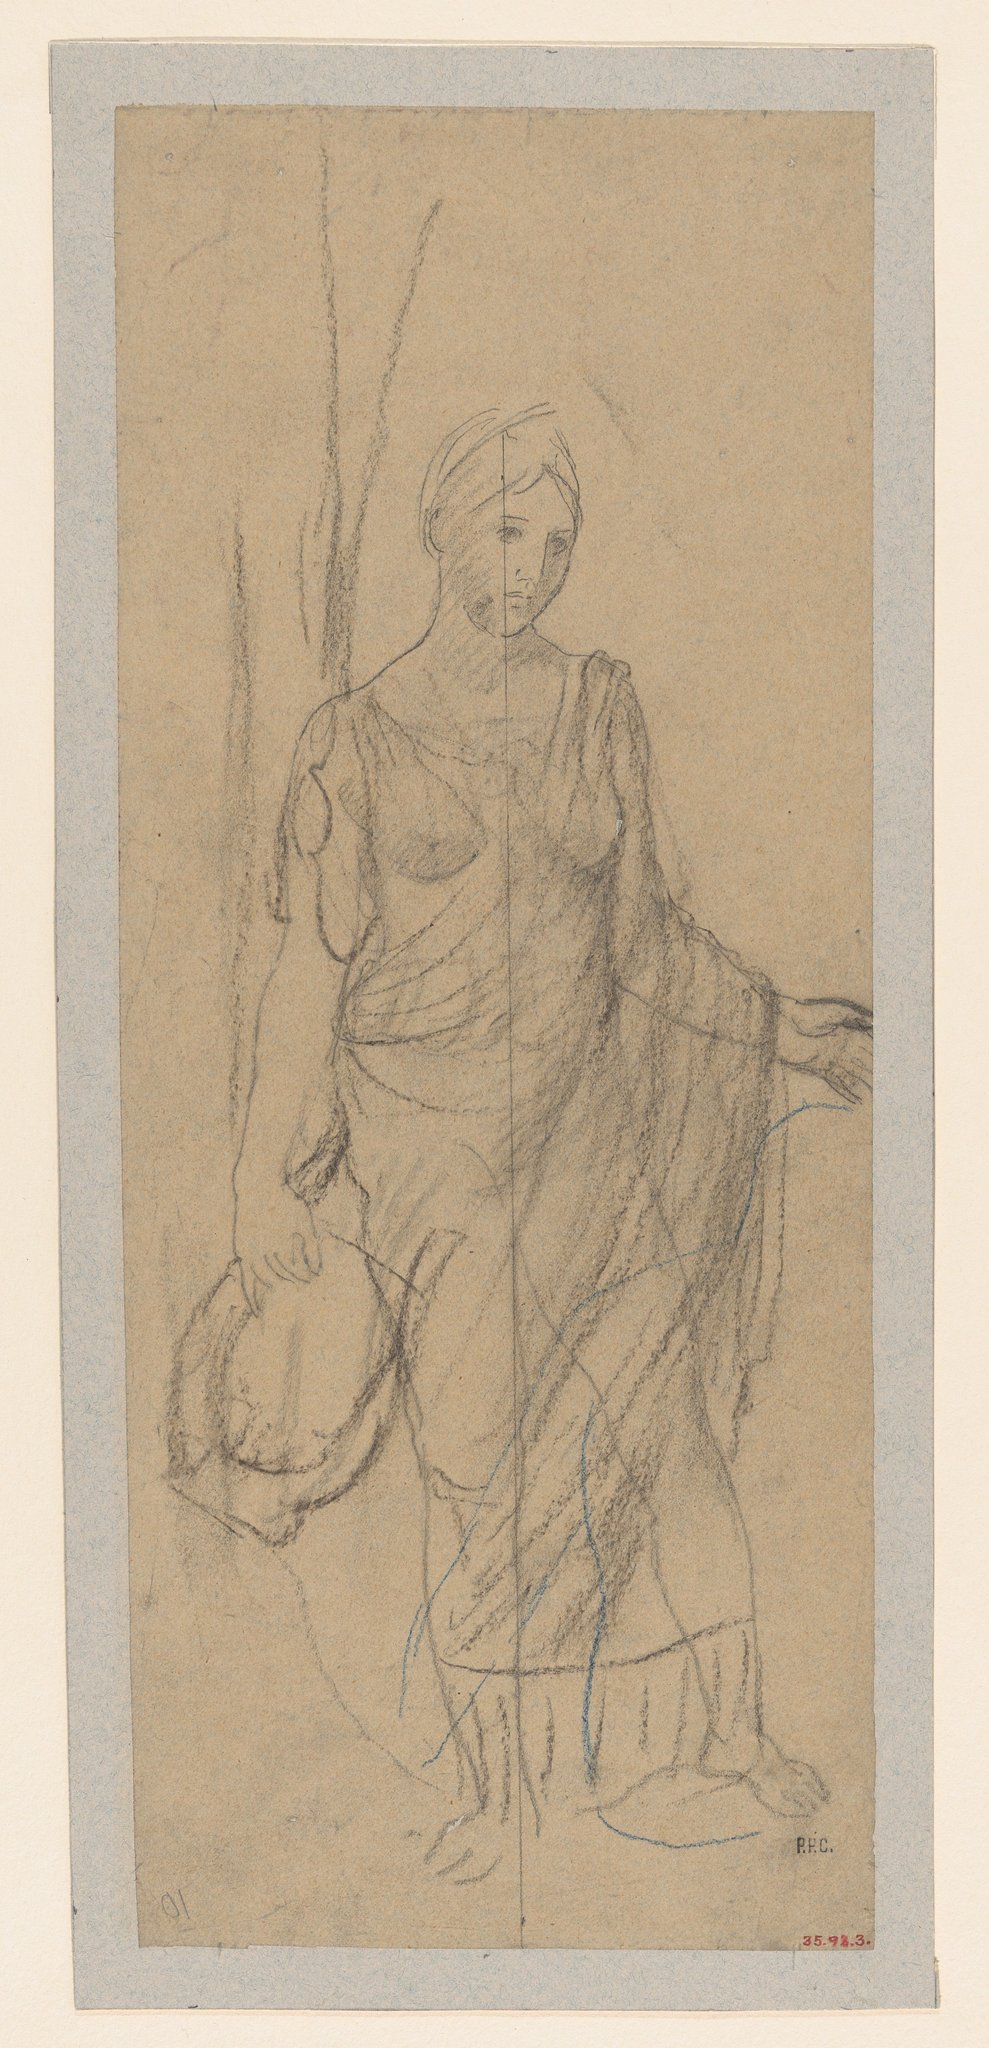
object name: drawing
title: A Muse of Poetry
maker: pierre puvis de chavannes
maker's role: artist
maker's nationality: french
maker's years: 1824-1898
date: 1801-1900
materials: chalk, graphite, paper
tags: poetry,muses